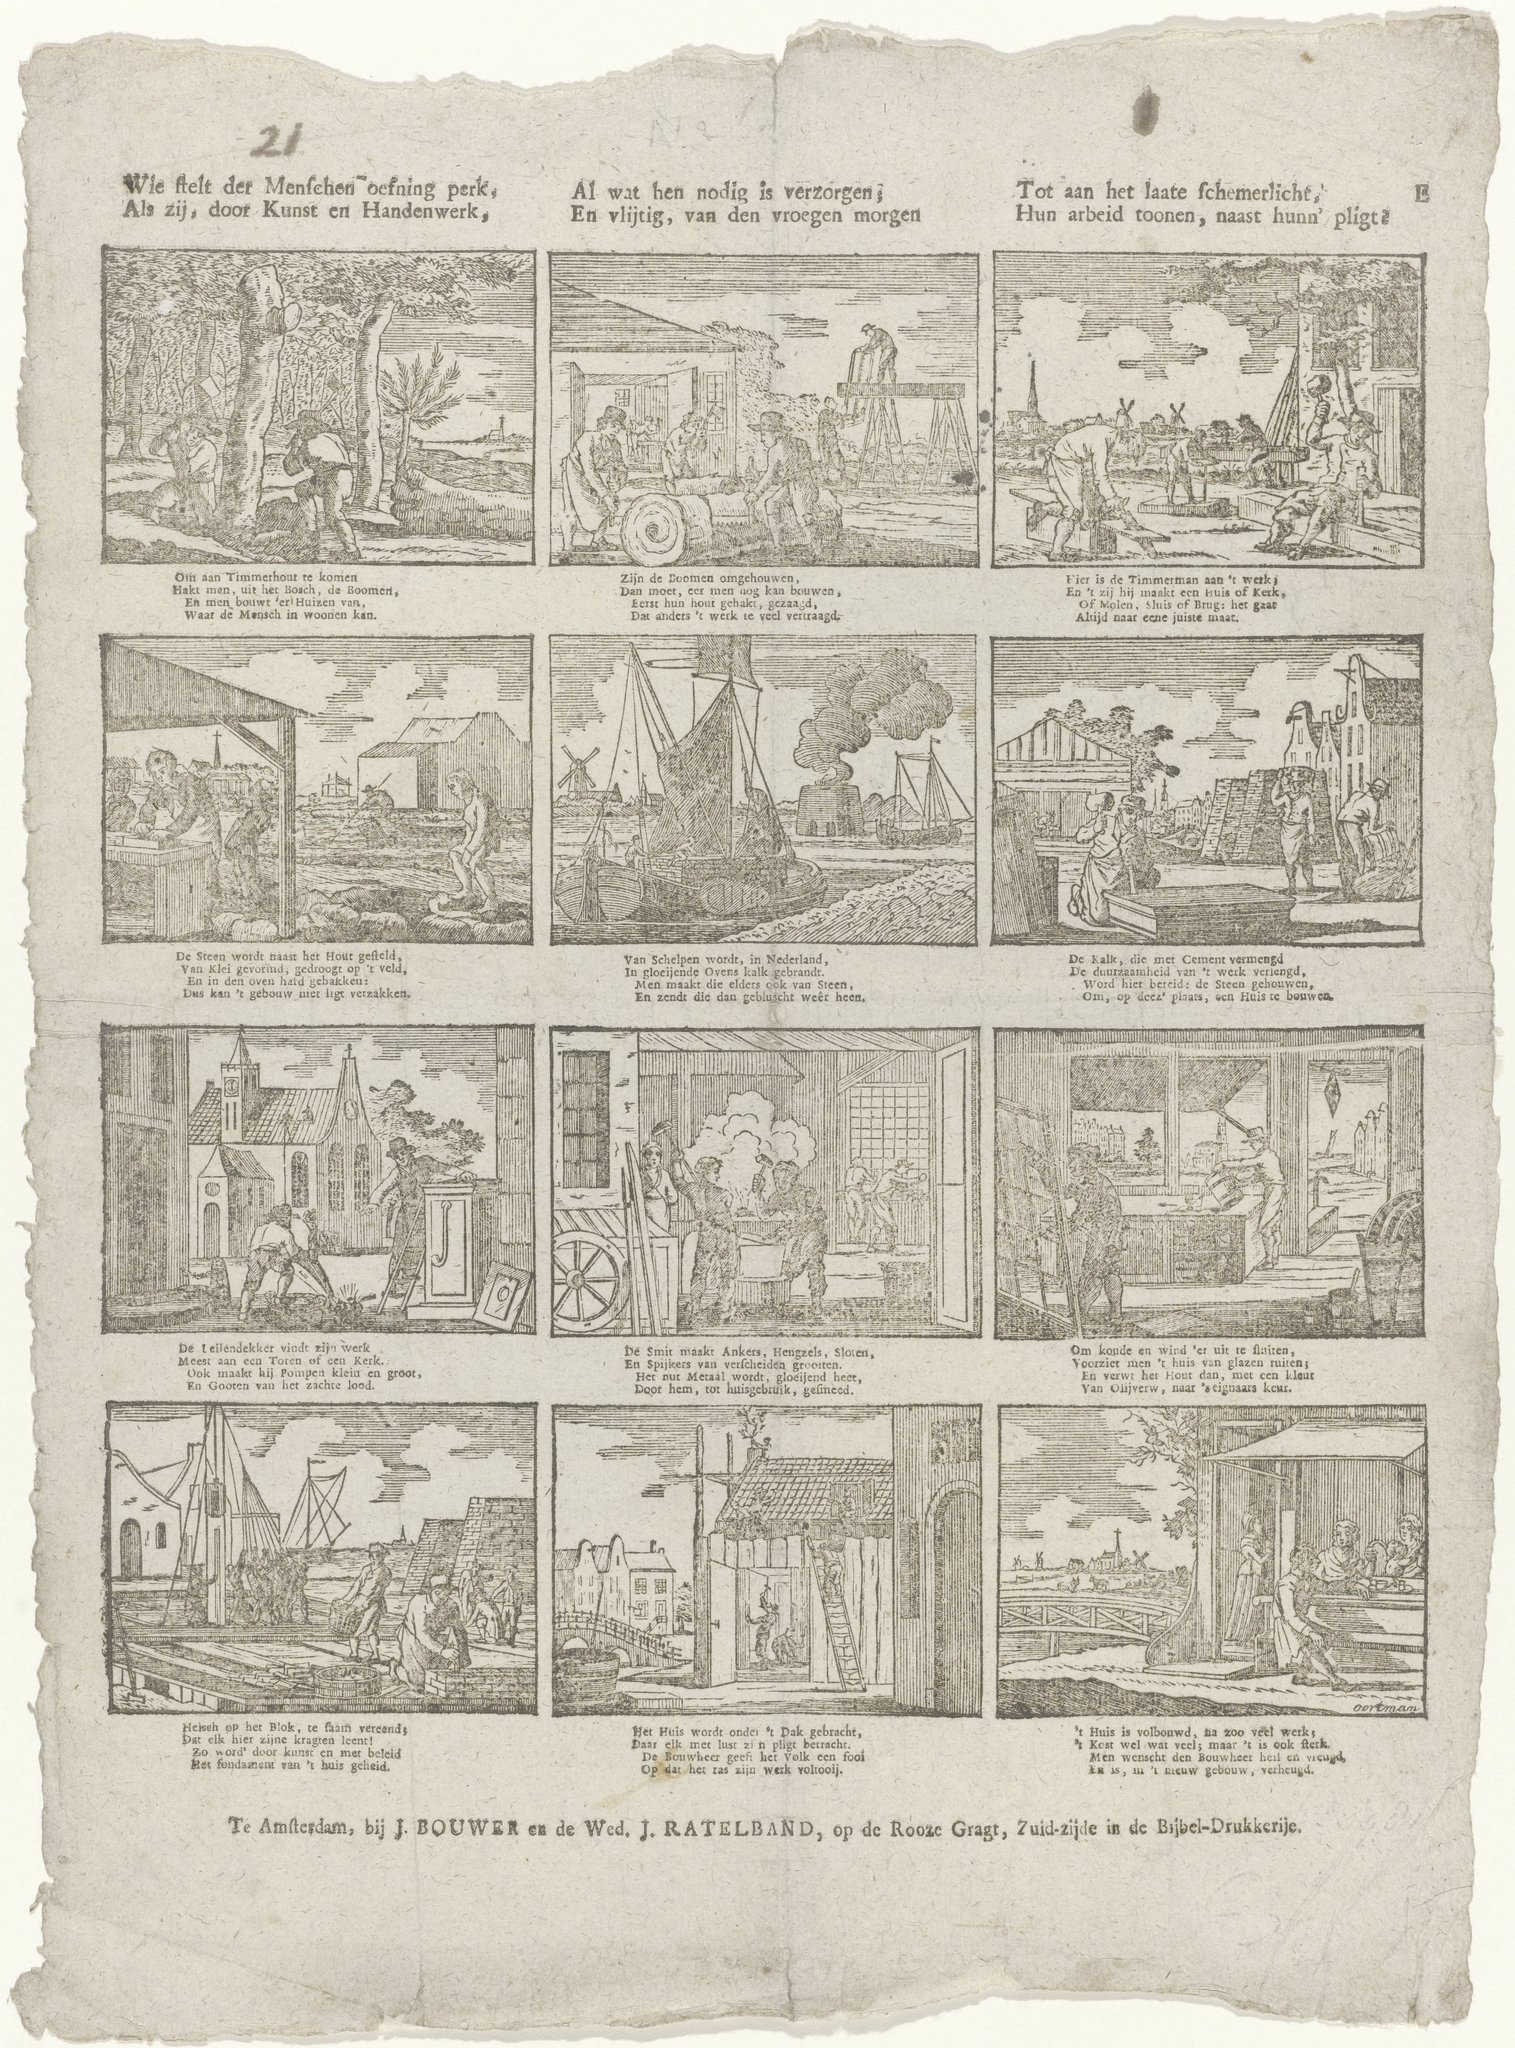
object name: print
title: Wie stelt der menschen oefning perk, / Als zij, door kunst en handenwerk (...)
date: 1794-1804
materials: paper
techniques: letterpress printing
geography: amsterdam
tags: handicrafts, craftsman at work, crafts and industries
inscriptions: inscription: ‘21’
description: Blad met 12 voorstellingen van verschillende ambachten. Onder elke afbeelding een vierregelig vers. Genummerd rechtsboven: E.